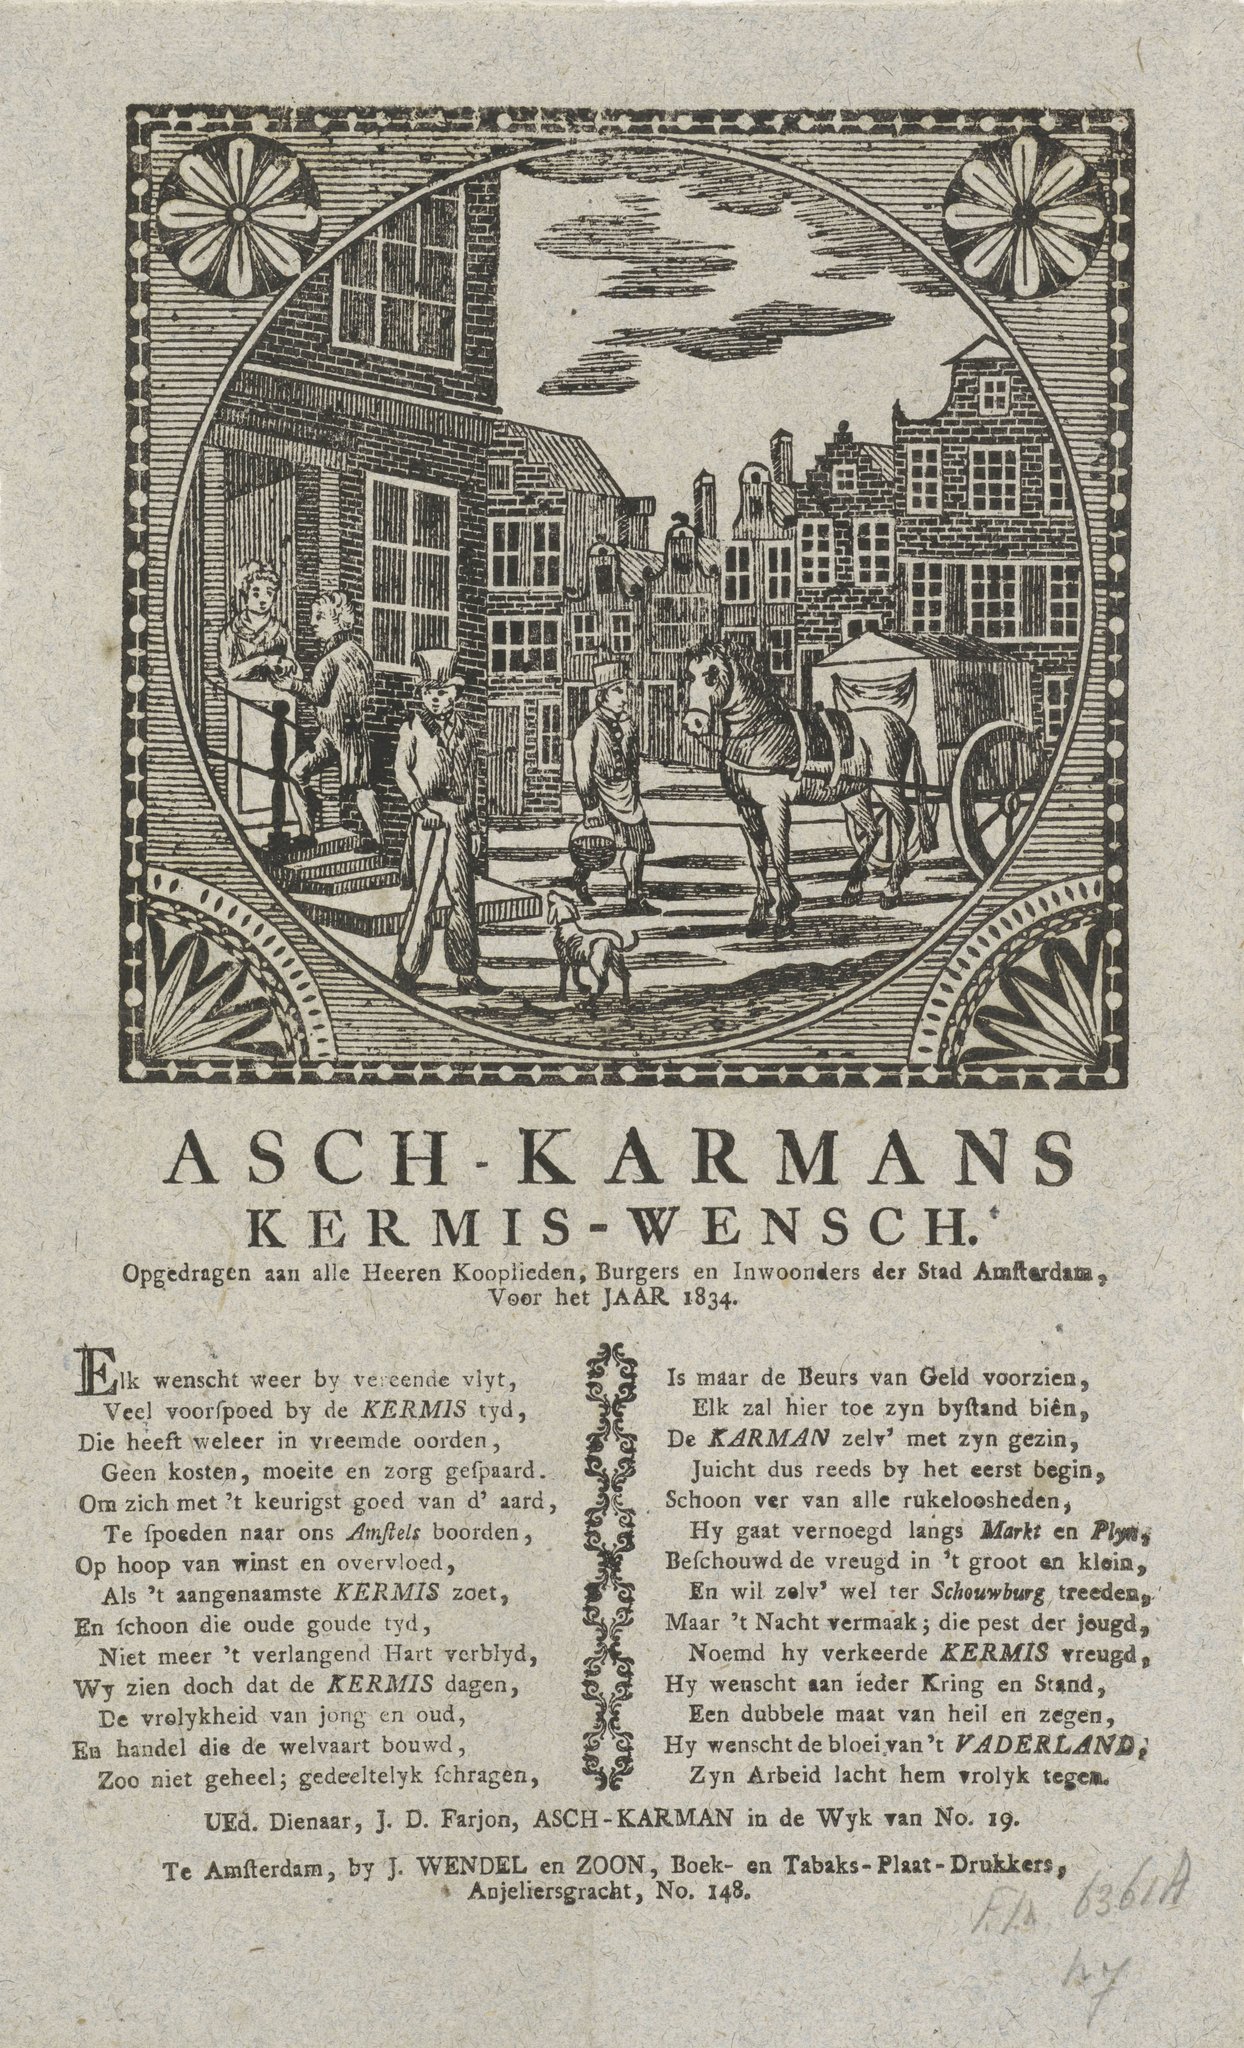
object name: print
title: Asch-Karmans Kermis-Wensch (...) 1834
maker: Anonymous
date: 1834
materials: paper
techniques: letterpress printing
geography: amsterdam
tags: public road - ii - ideal city, garbage collection, amsterdam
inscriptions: collector's mark: Lugt 2228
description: Kermisprent namens de askarrenmannen (karrenman of vuilnisman) te Amsterdam voor het jaar 1834. Gezicht in een straat te Amsterdam met een man die een asemmer naar de kar brengt terwijl een andere man aan huis geld ophaalt. Onderaan een gedicht in twee kolommen. Namens J.D. Farjon, de askarreman van wijk no. 19.